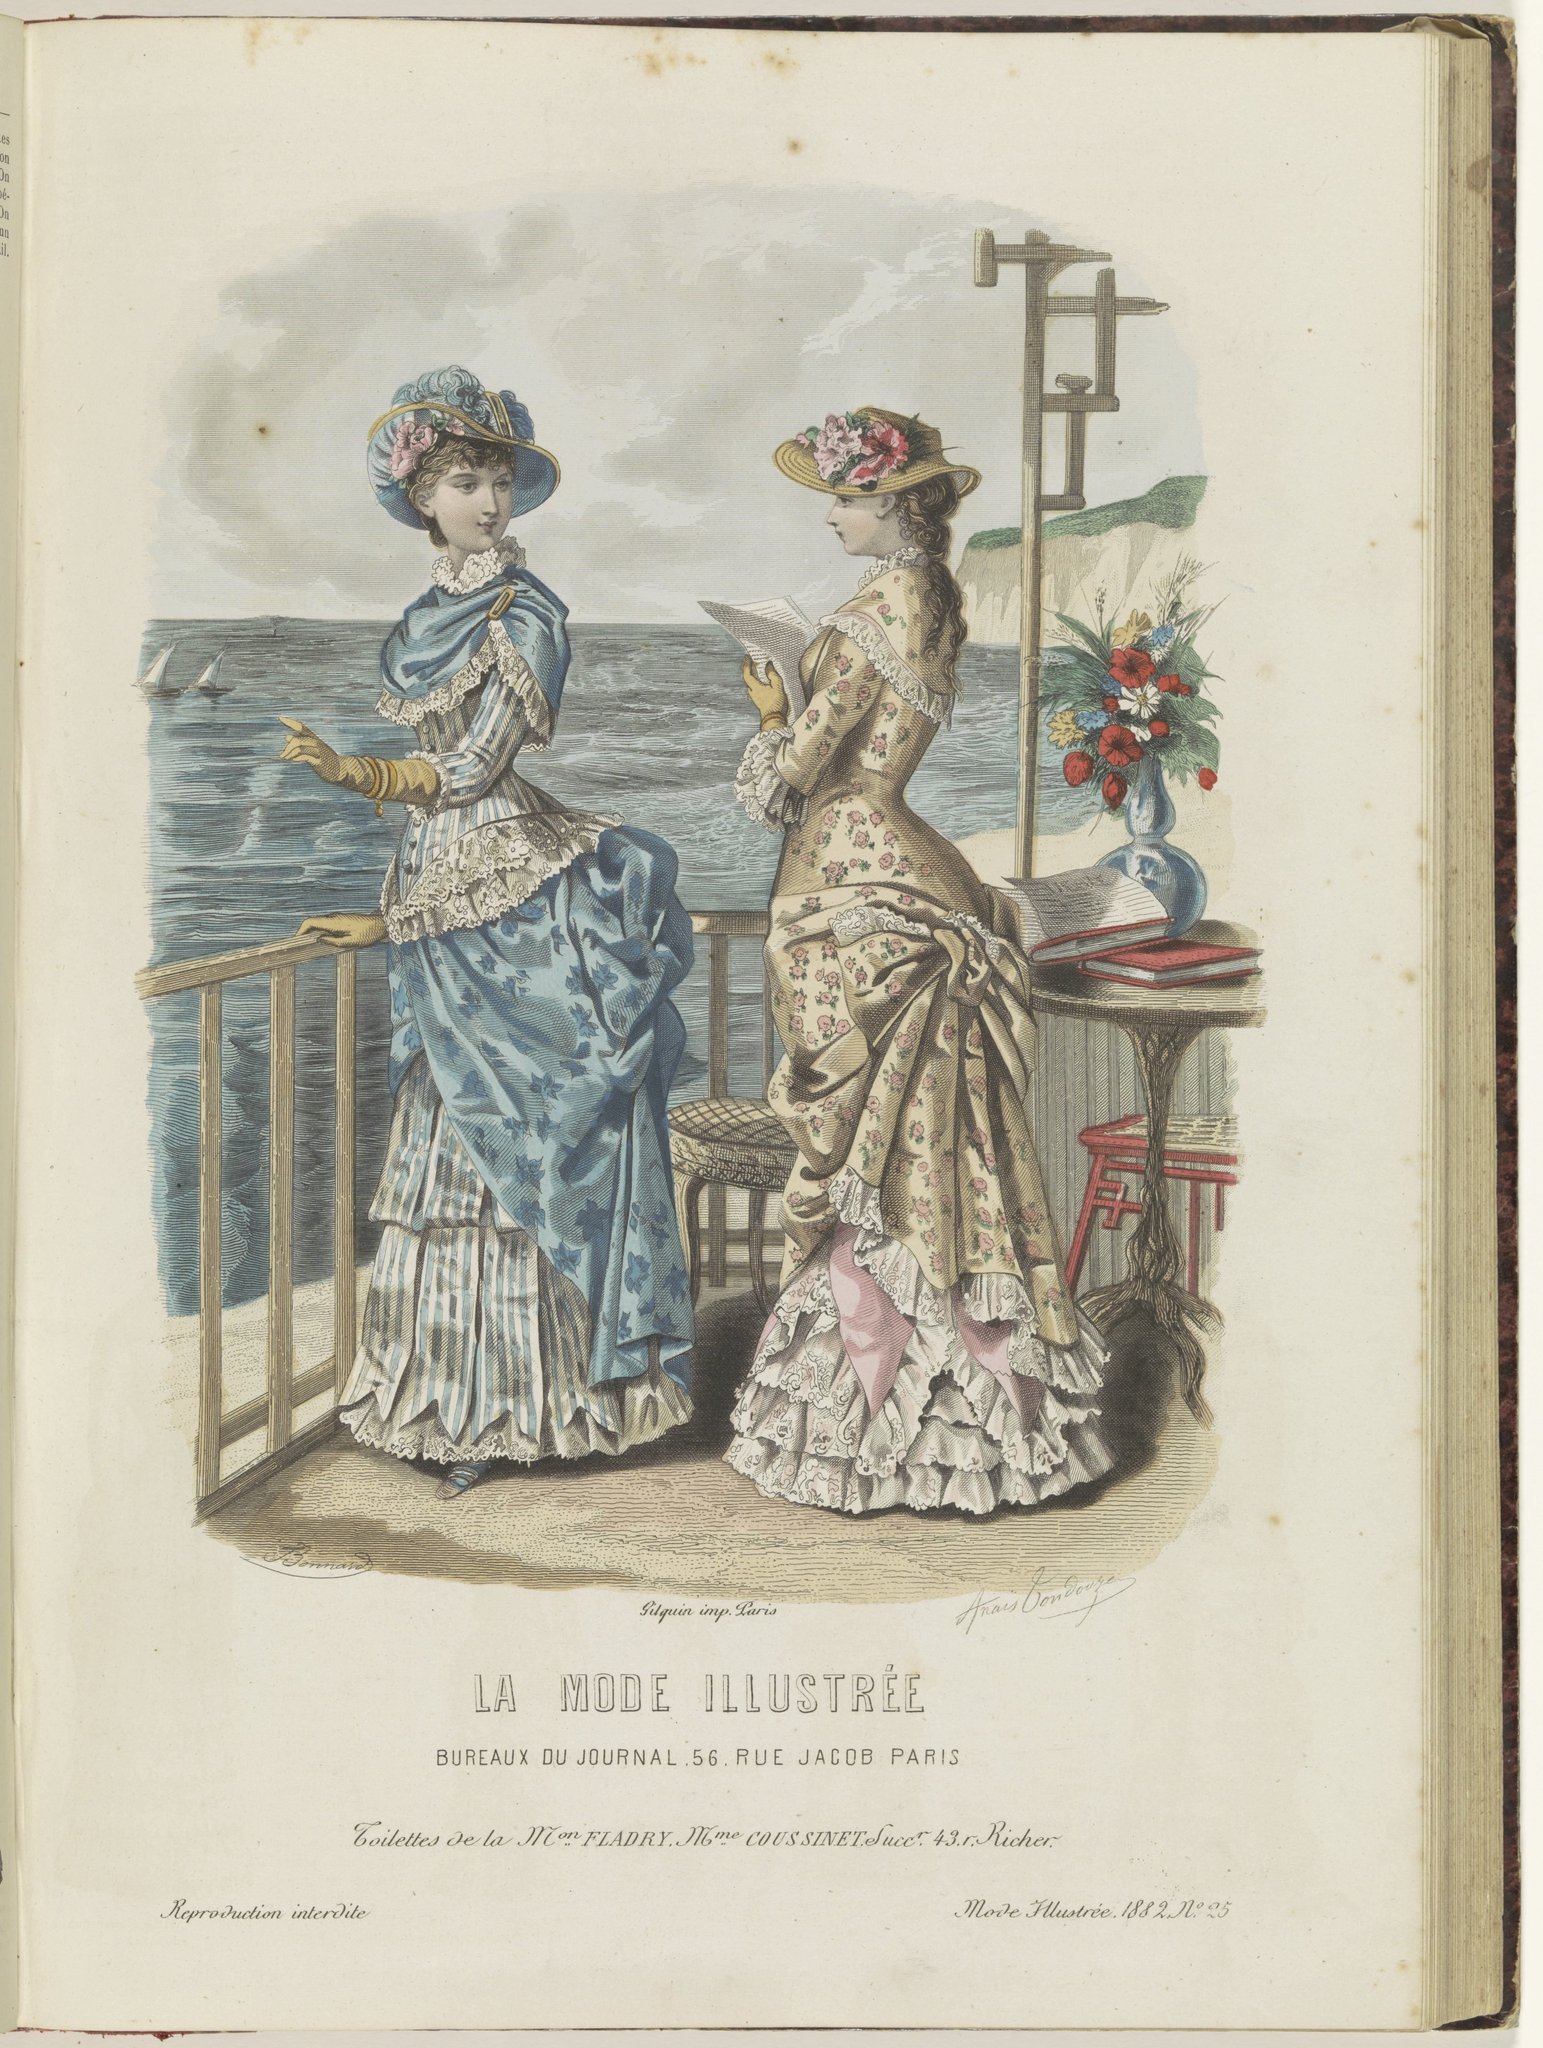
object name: magazine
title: La Mode Illustrée, Journal de la Famille, 1882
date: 1882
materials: paper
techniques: engraving, hand coloring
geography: paris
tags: fashion plates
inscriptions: date